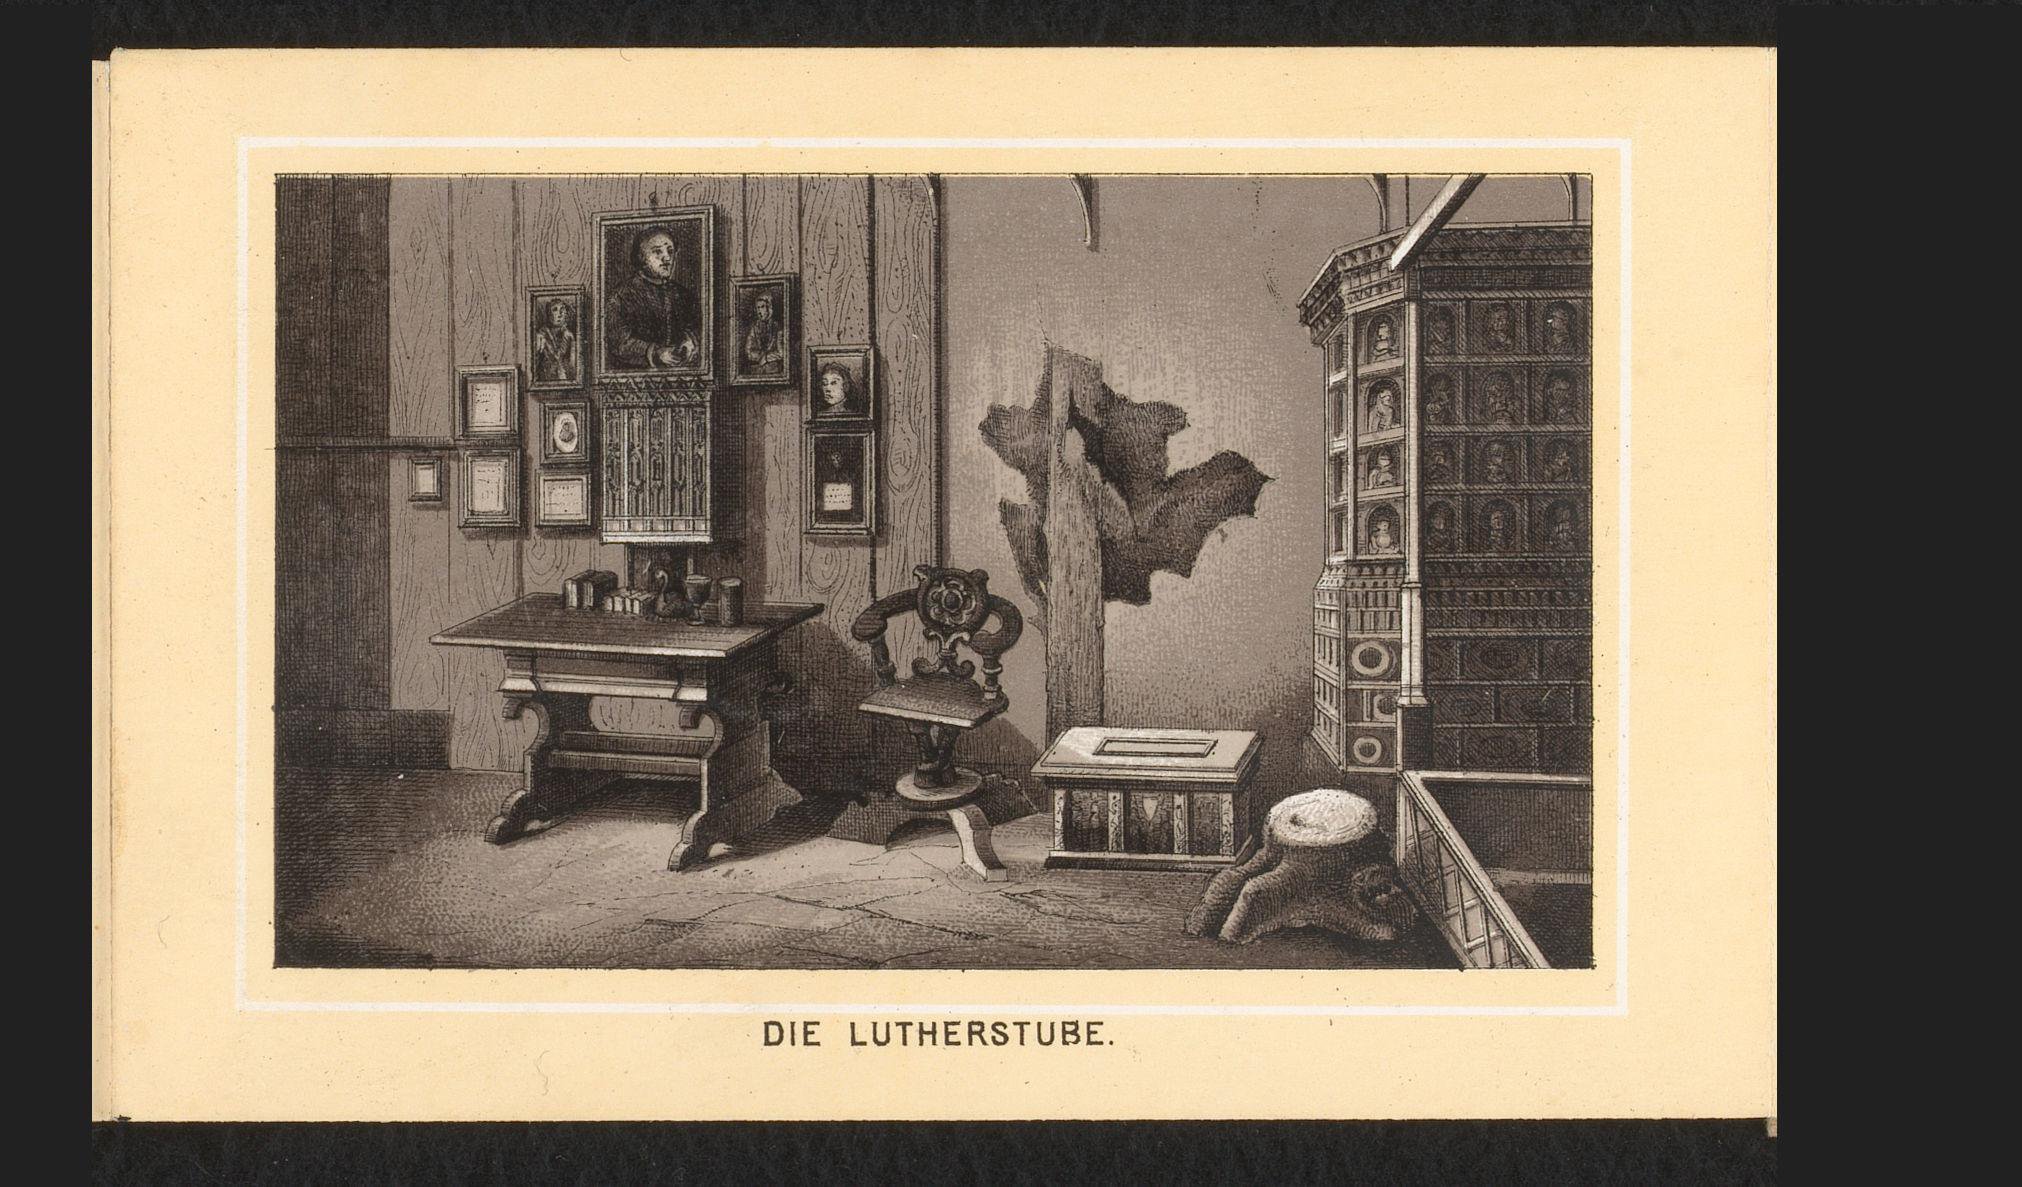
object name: photomechanical print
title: Die Lutherstube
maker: louis glaser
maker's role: printer, publisher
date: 1874-1900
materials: cardboard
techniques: photolithography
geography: leipzig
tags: castle, study; 'studiolo'; library